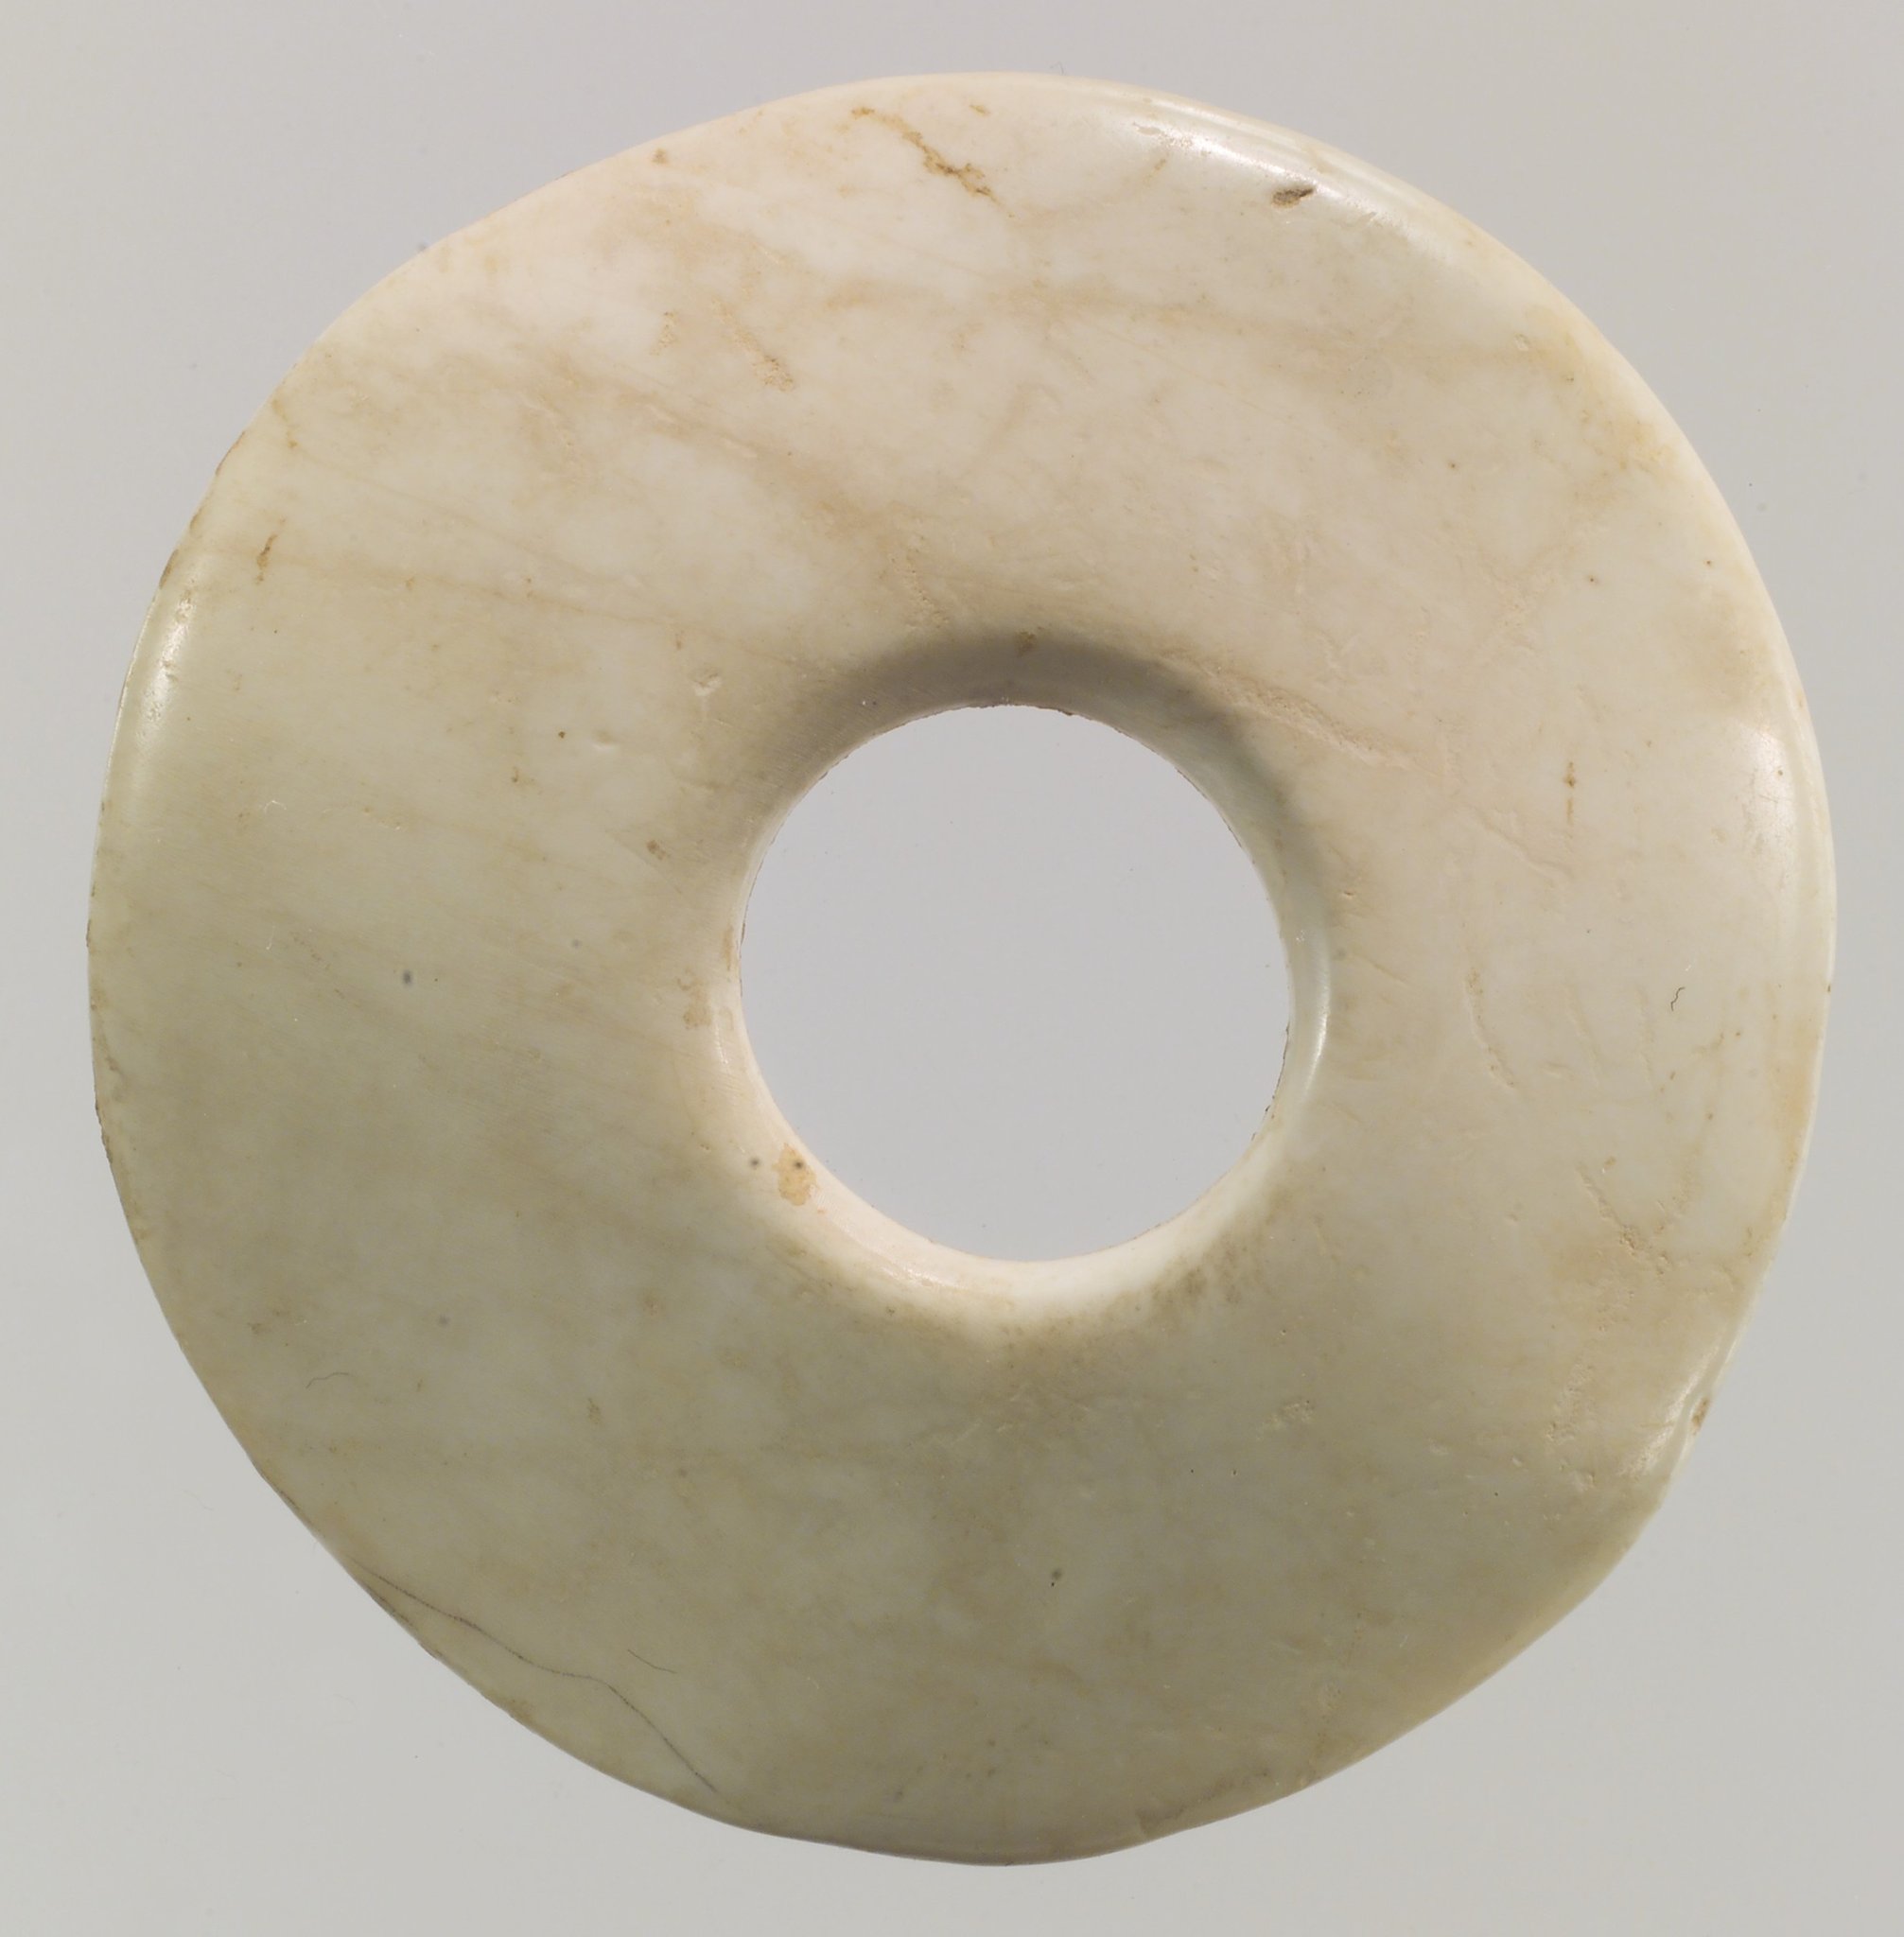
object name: button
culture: sasanian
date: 201-700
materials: shell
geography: iran